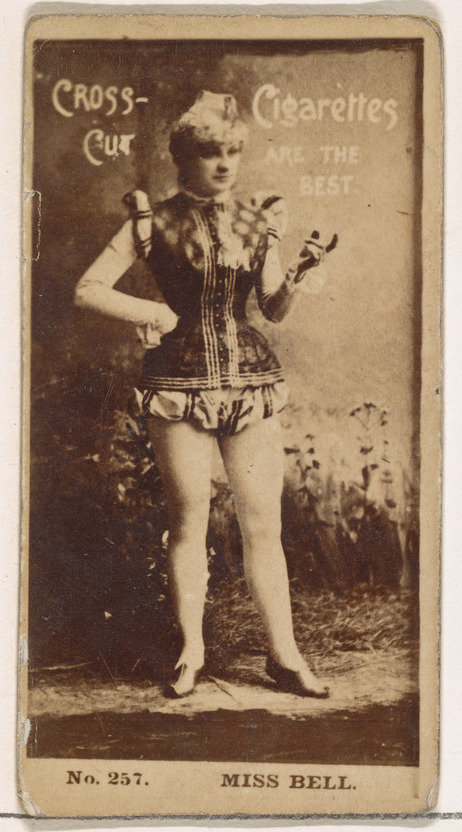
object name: print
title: Card Number 257, Miss Bell, from the Actors and Actresses series (N145-2) issued by Duke Sons & Co. to promote Cross Cut Cigarettes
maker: w. duke, sons & co.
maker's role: publisher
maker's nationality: american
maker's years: 1870-1920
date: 1880-1889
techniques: albumen silver print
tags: portraits,women,actresses